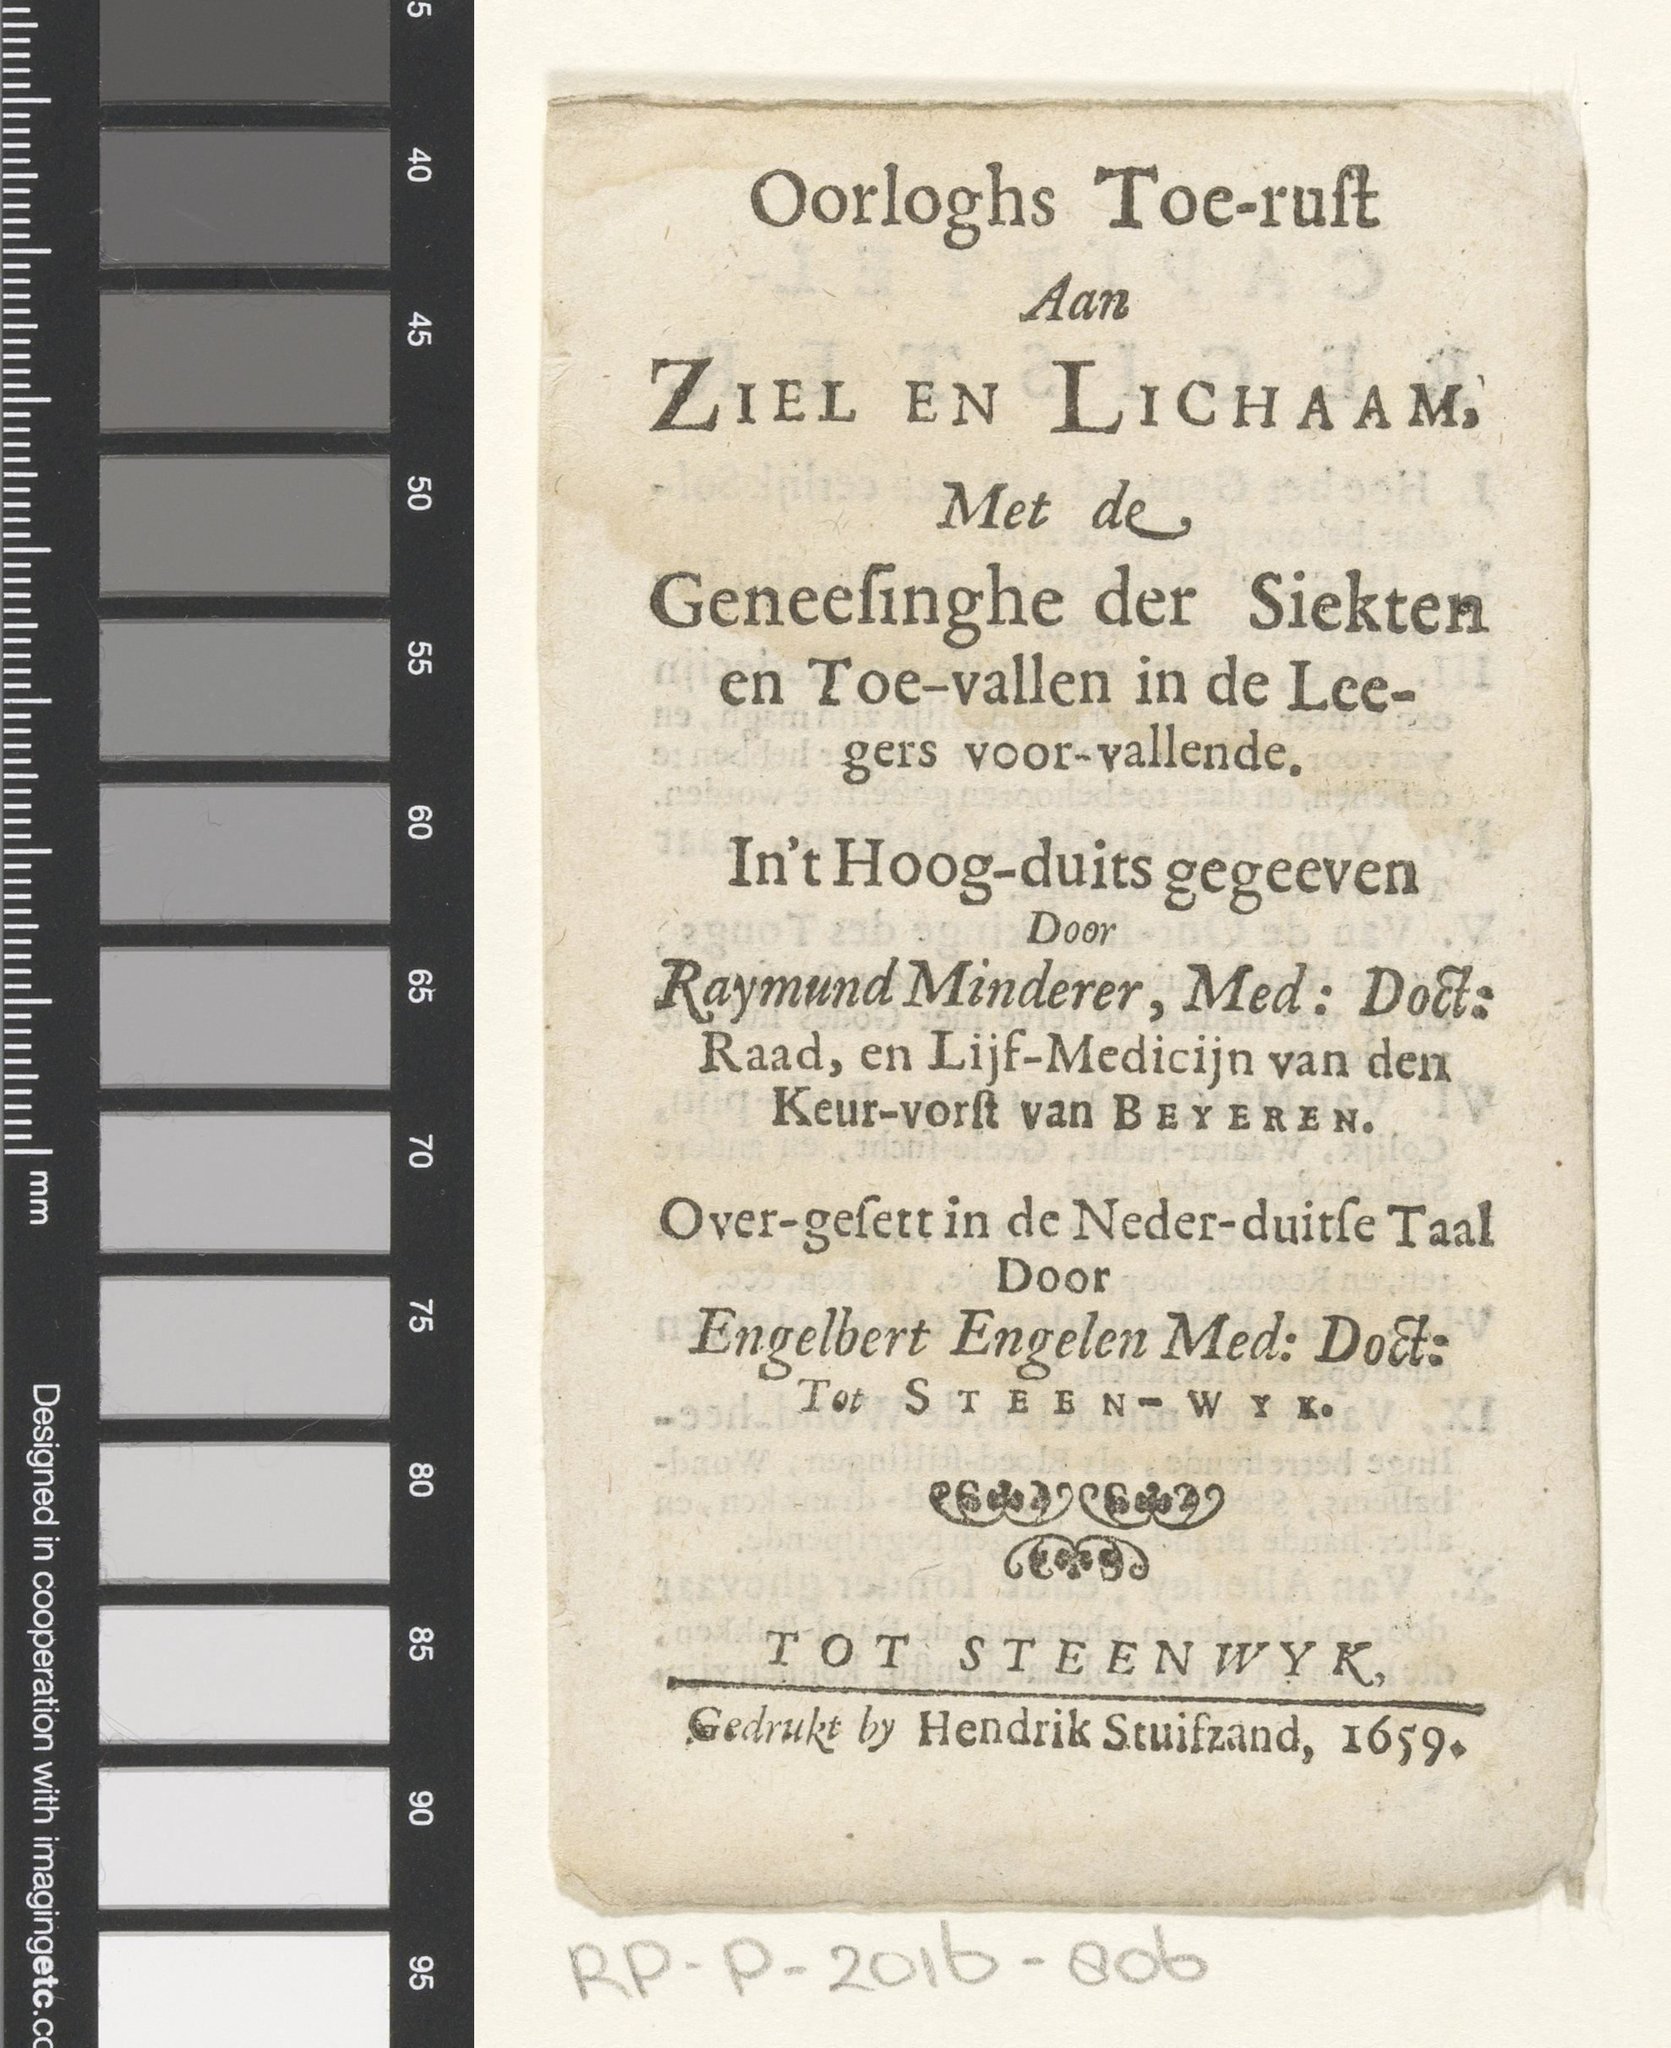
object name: print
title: Titelpagina voor: Raymund Minderer en Engelbert Engelen, Oorloghs Toe-rust Aan Zien en Lichaam, 1659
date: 1659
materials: paper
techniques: letterpress printing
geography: steenwijk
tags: title-page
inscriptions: date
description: Titelpagina voor: Minderer, Raymund en Engelen, Engelbert. Oorloghs Toe-rust Aan Zien en Lichaam. Steenwijk: Stuifzand, Hendrik, 1659.